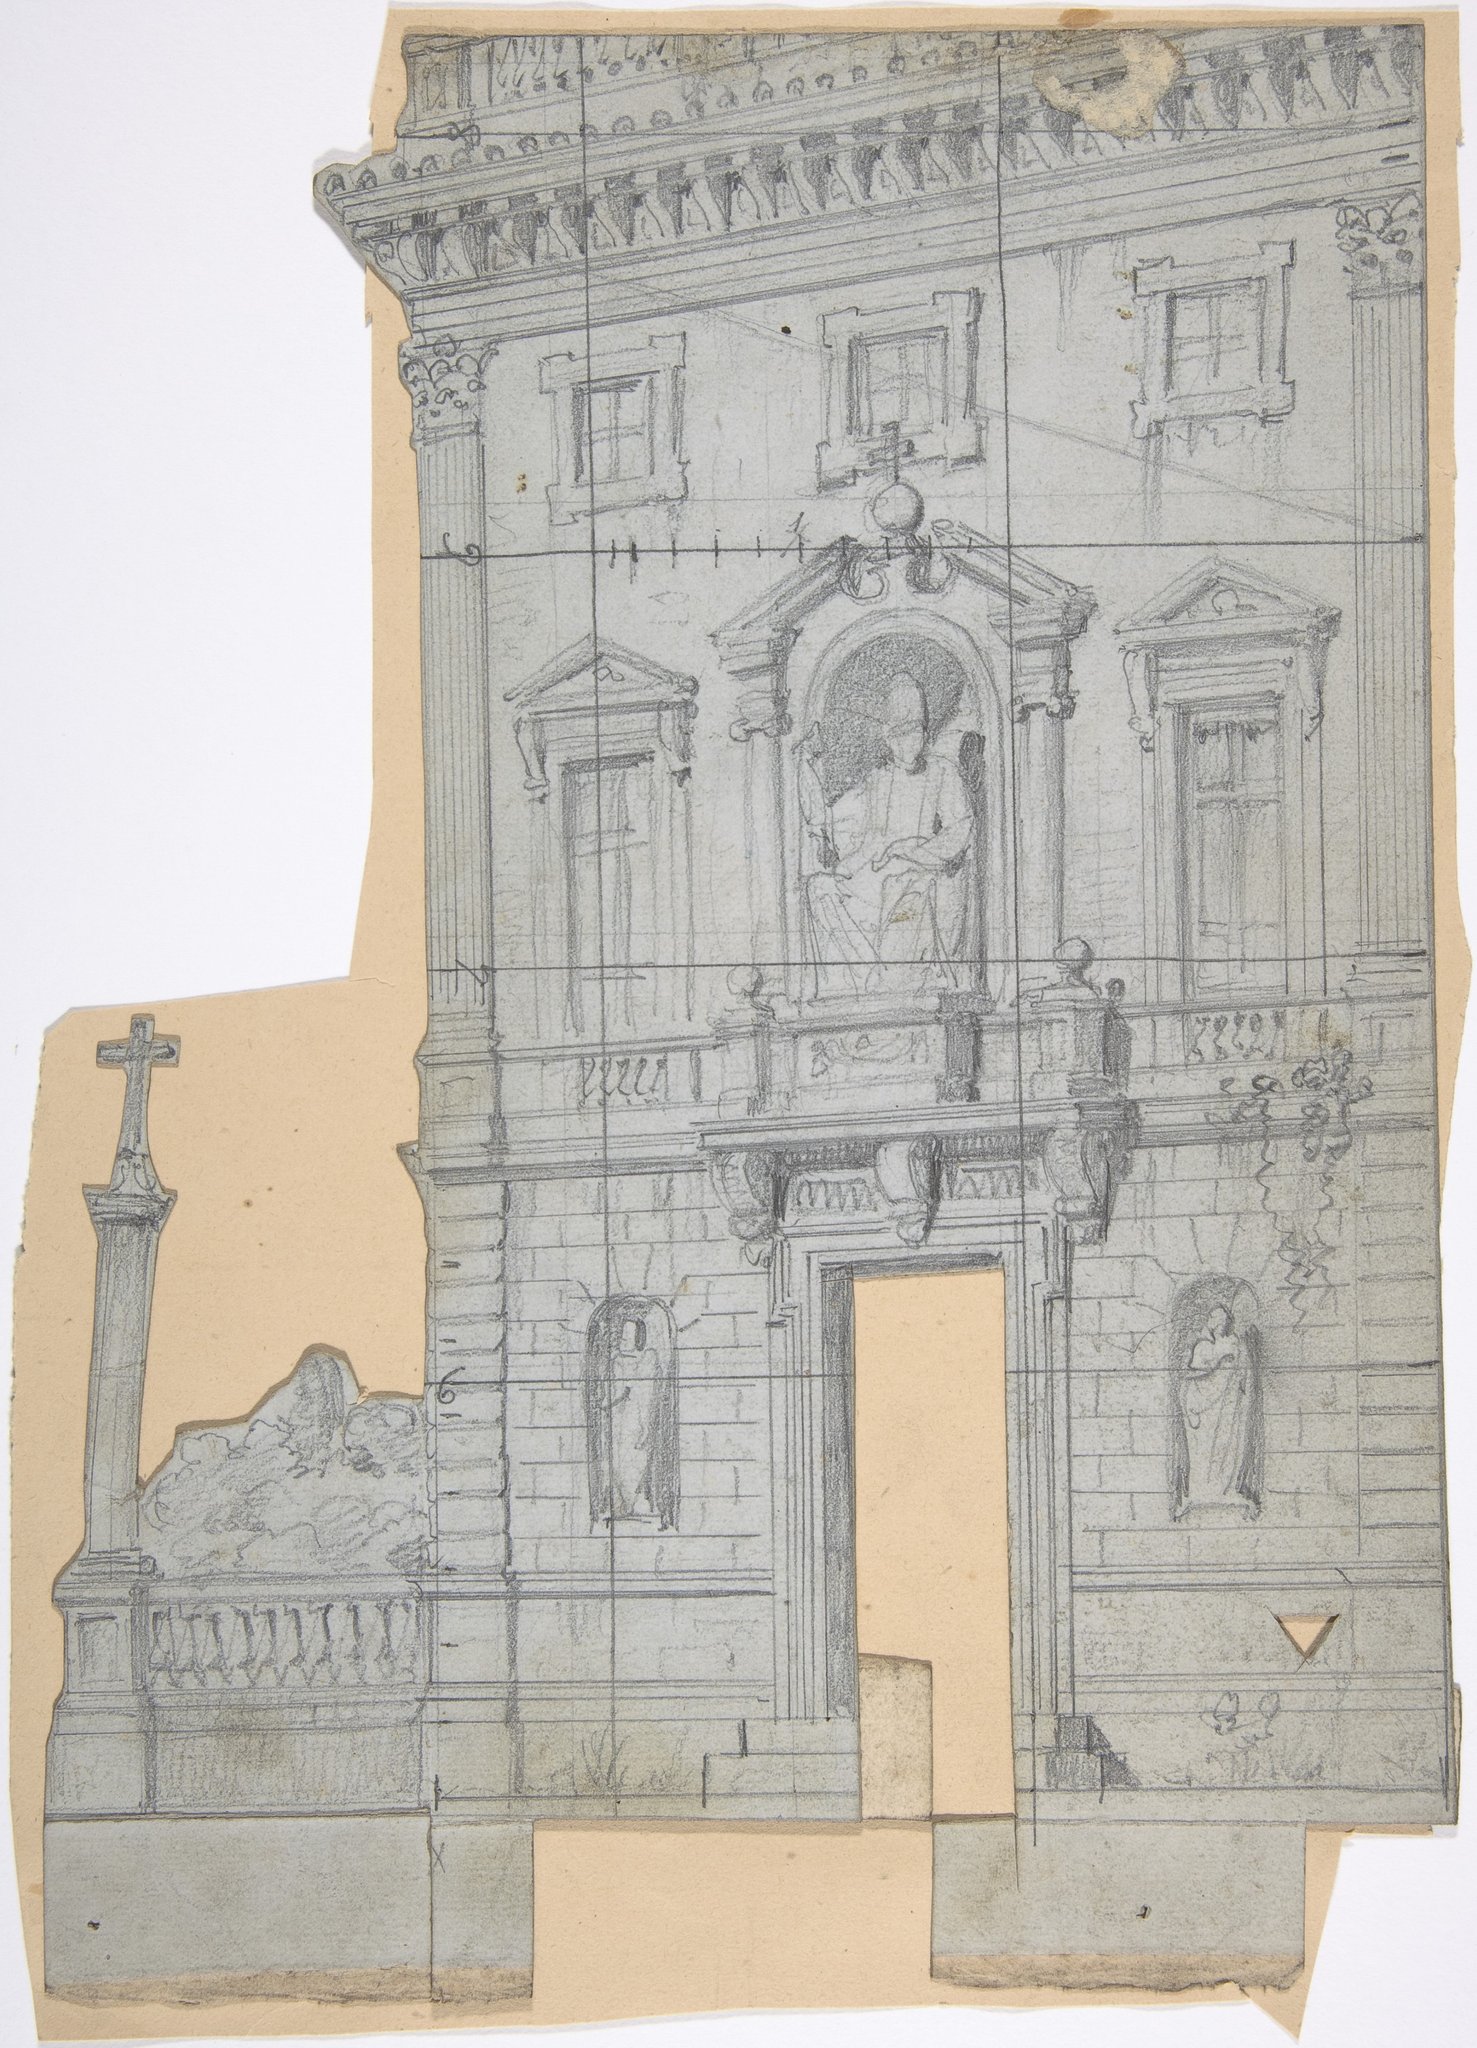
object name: drawing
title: Design for a Stage Set at the Opéra, Paris: Building Façade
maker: eugène cicéri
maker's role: artist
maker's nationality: french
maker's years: 1813-1890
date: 1830-1890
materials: graphite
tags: buildings,stage design